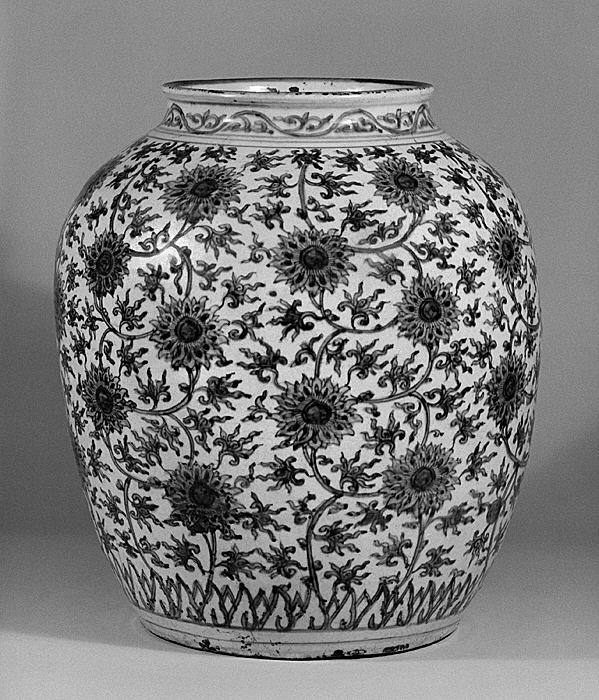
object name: jar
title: Jar with lotus scrolls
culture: chinese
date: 1567-1600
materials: cobalt, porcelain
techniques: painting, underglaze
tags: flowers